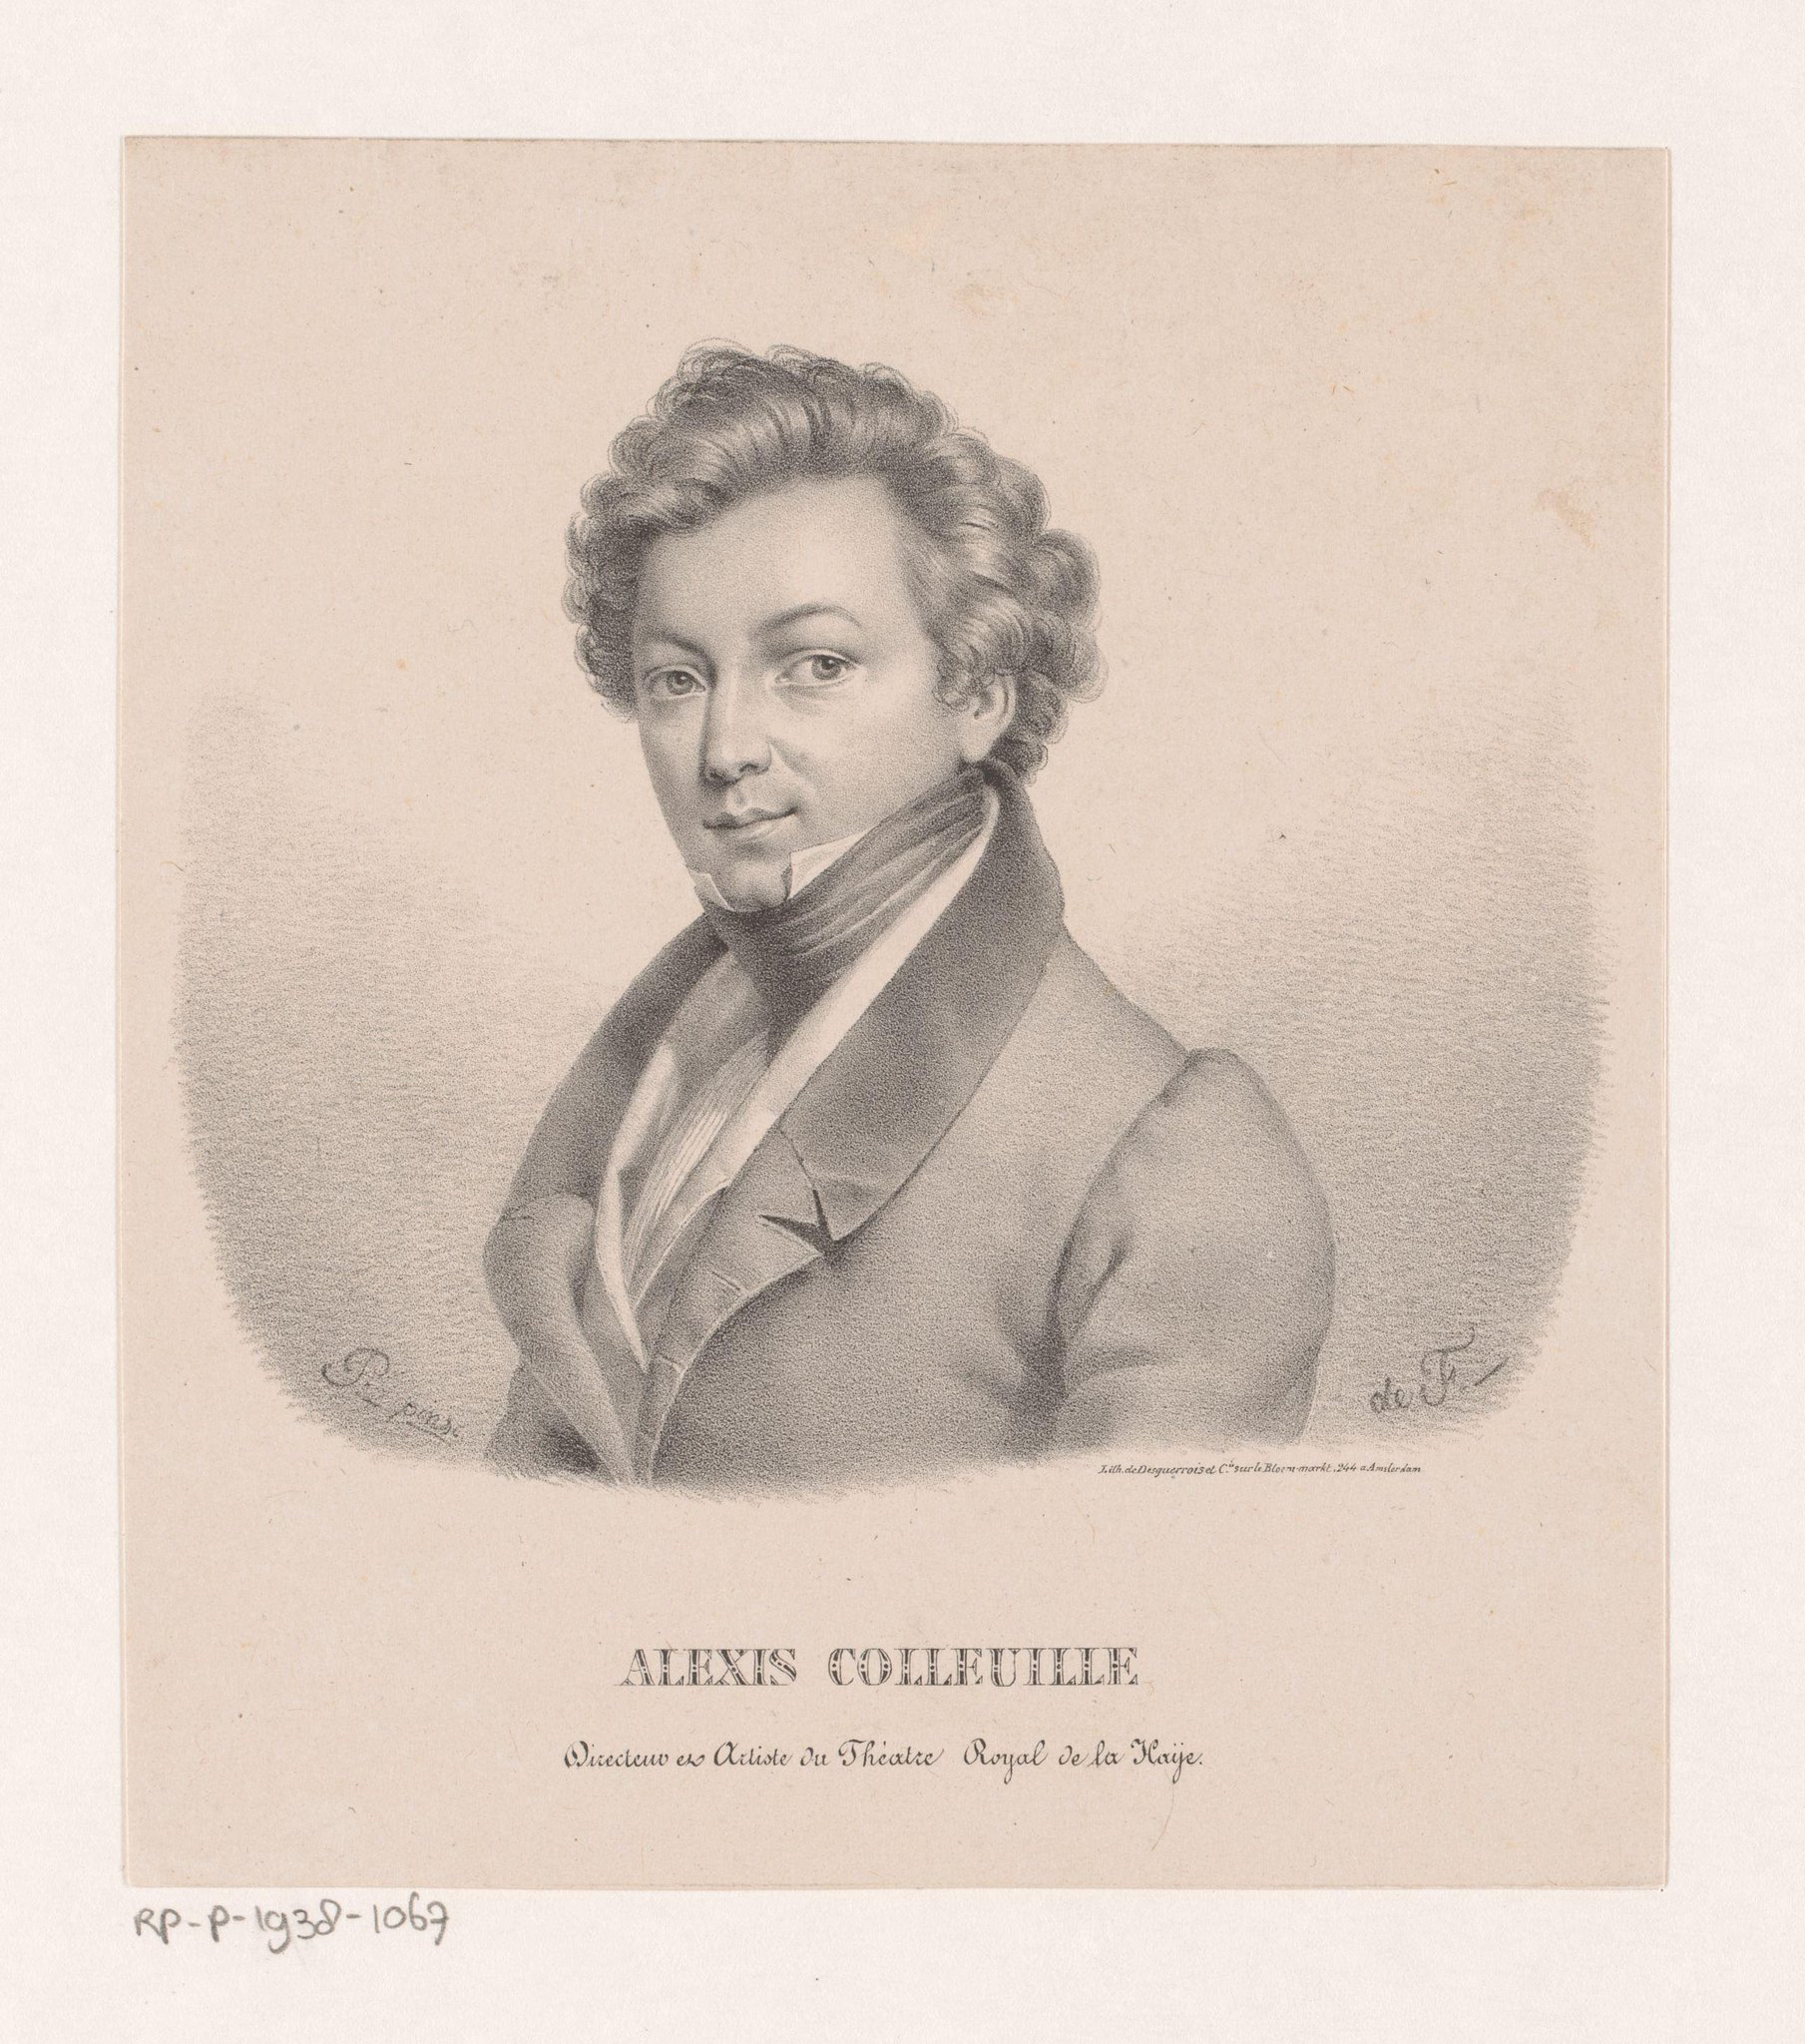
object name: print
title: Portret van Alexis Callemille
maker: louis henri de fontenay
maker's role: draughtsman, print maker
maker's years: 1800-1872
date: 1810-1872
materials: paper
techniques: lithograph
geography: amsterdam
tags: historical persons (+ (full) bust portrait)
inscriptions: collector's mark: Lugt 2228, collector's mark: Lugt 2760, :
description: De geportretteerde zit naar links gewend en draagt een hoge opstaande kraag. Onder het portret zijn naam en beroep. Linksonder in de voorstelling staat een monogram: P. Pinx.